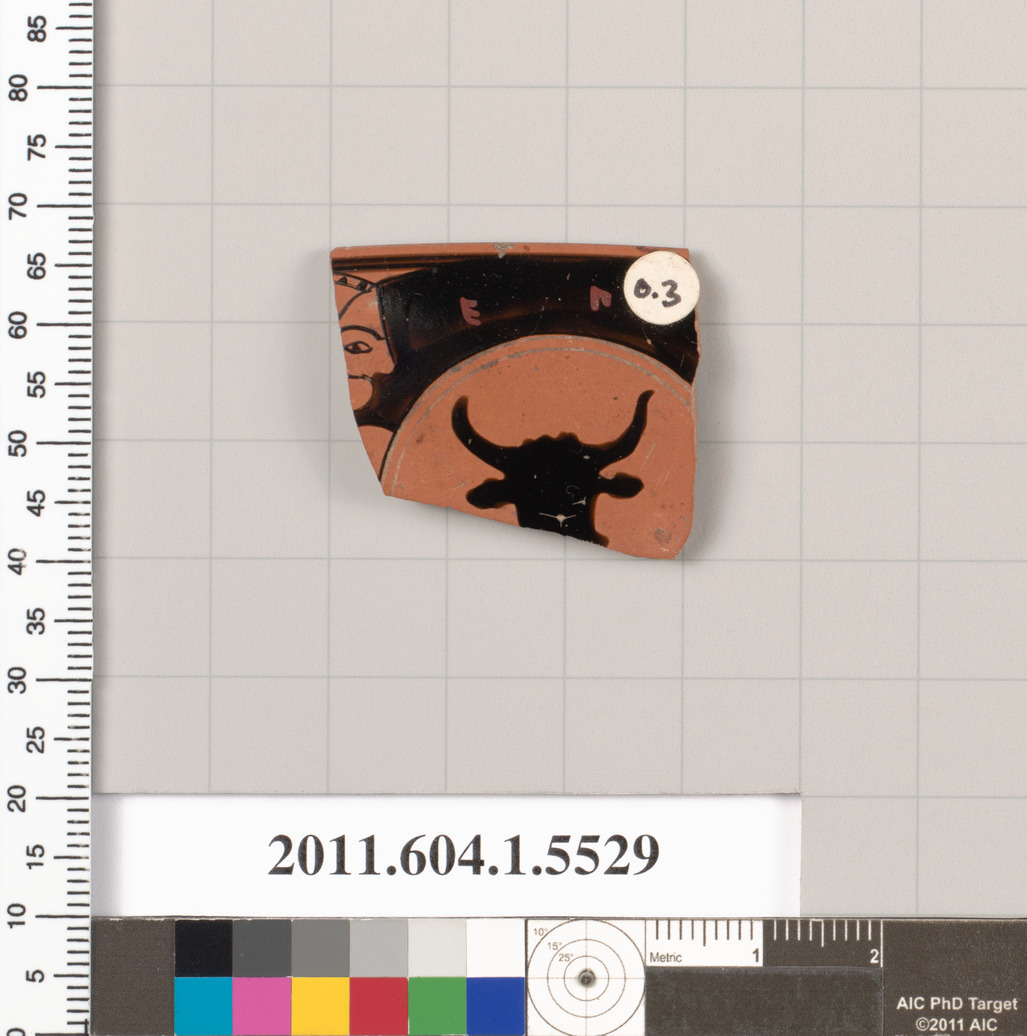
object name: kylix fragment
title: Terracotta rim fragment of a kylix (drinking cup)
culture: greek, attic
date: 510-500 BCE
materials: terracotta